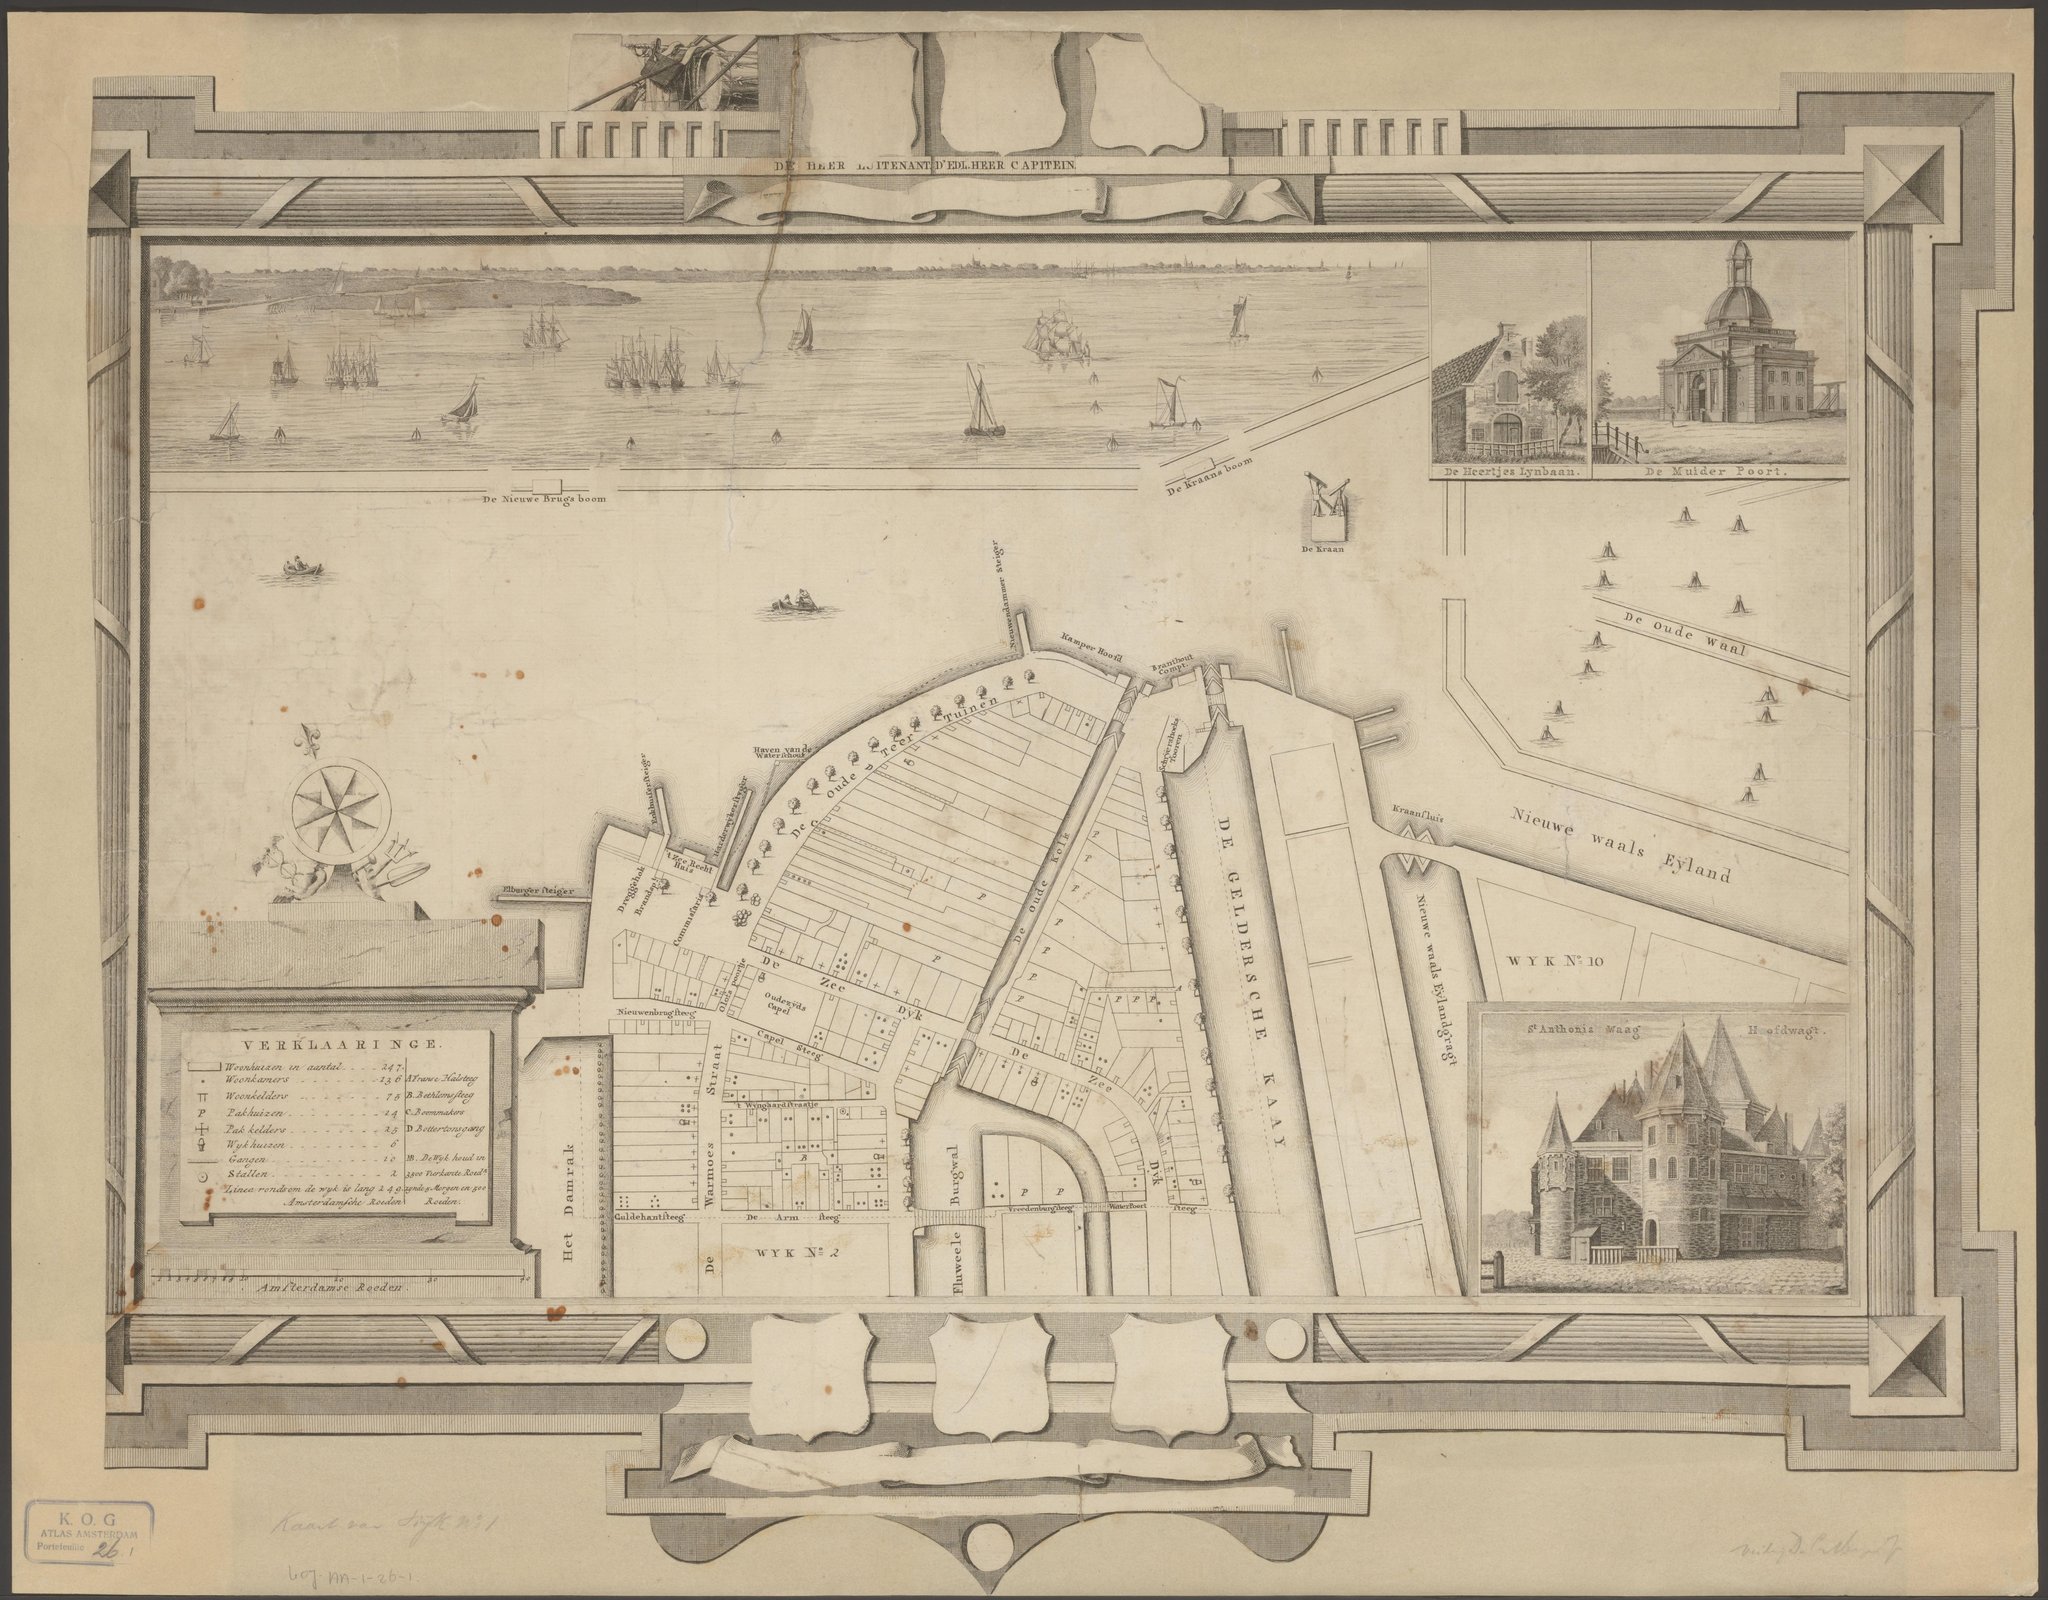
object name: area plan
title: Plattegrond van burgerwijk I te Amsterdam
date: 1794-1800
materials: paper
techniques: engraving, etching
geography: amsterdam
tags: landscapes with waters, waterscapes, seascapes (in the temperate zone), maps of cities, civic architecture; edifices; dwellings, amsterdam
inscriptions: collector's mark: Lugt 1641b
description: Op eerdere staat staan de wapenschilden van kapitein Johan Cornelis Bert, luitenant Hendrik Ruttens, vaandrig - het schild is leeg en een naam ontbreekt - en de sergeanten Jan Casper Zeeweke, Hendrik Slykhuys en Wouter Brave. Deze (onder)officieren van de wacht waren in de jaren 1794-1795 in deze combinatie in functie.